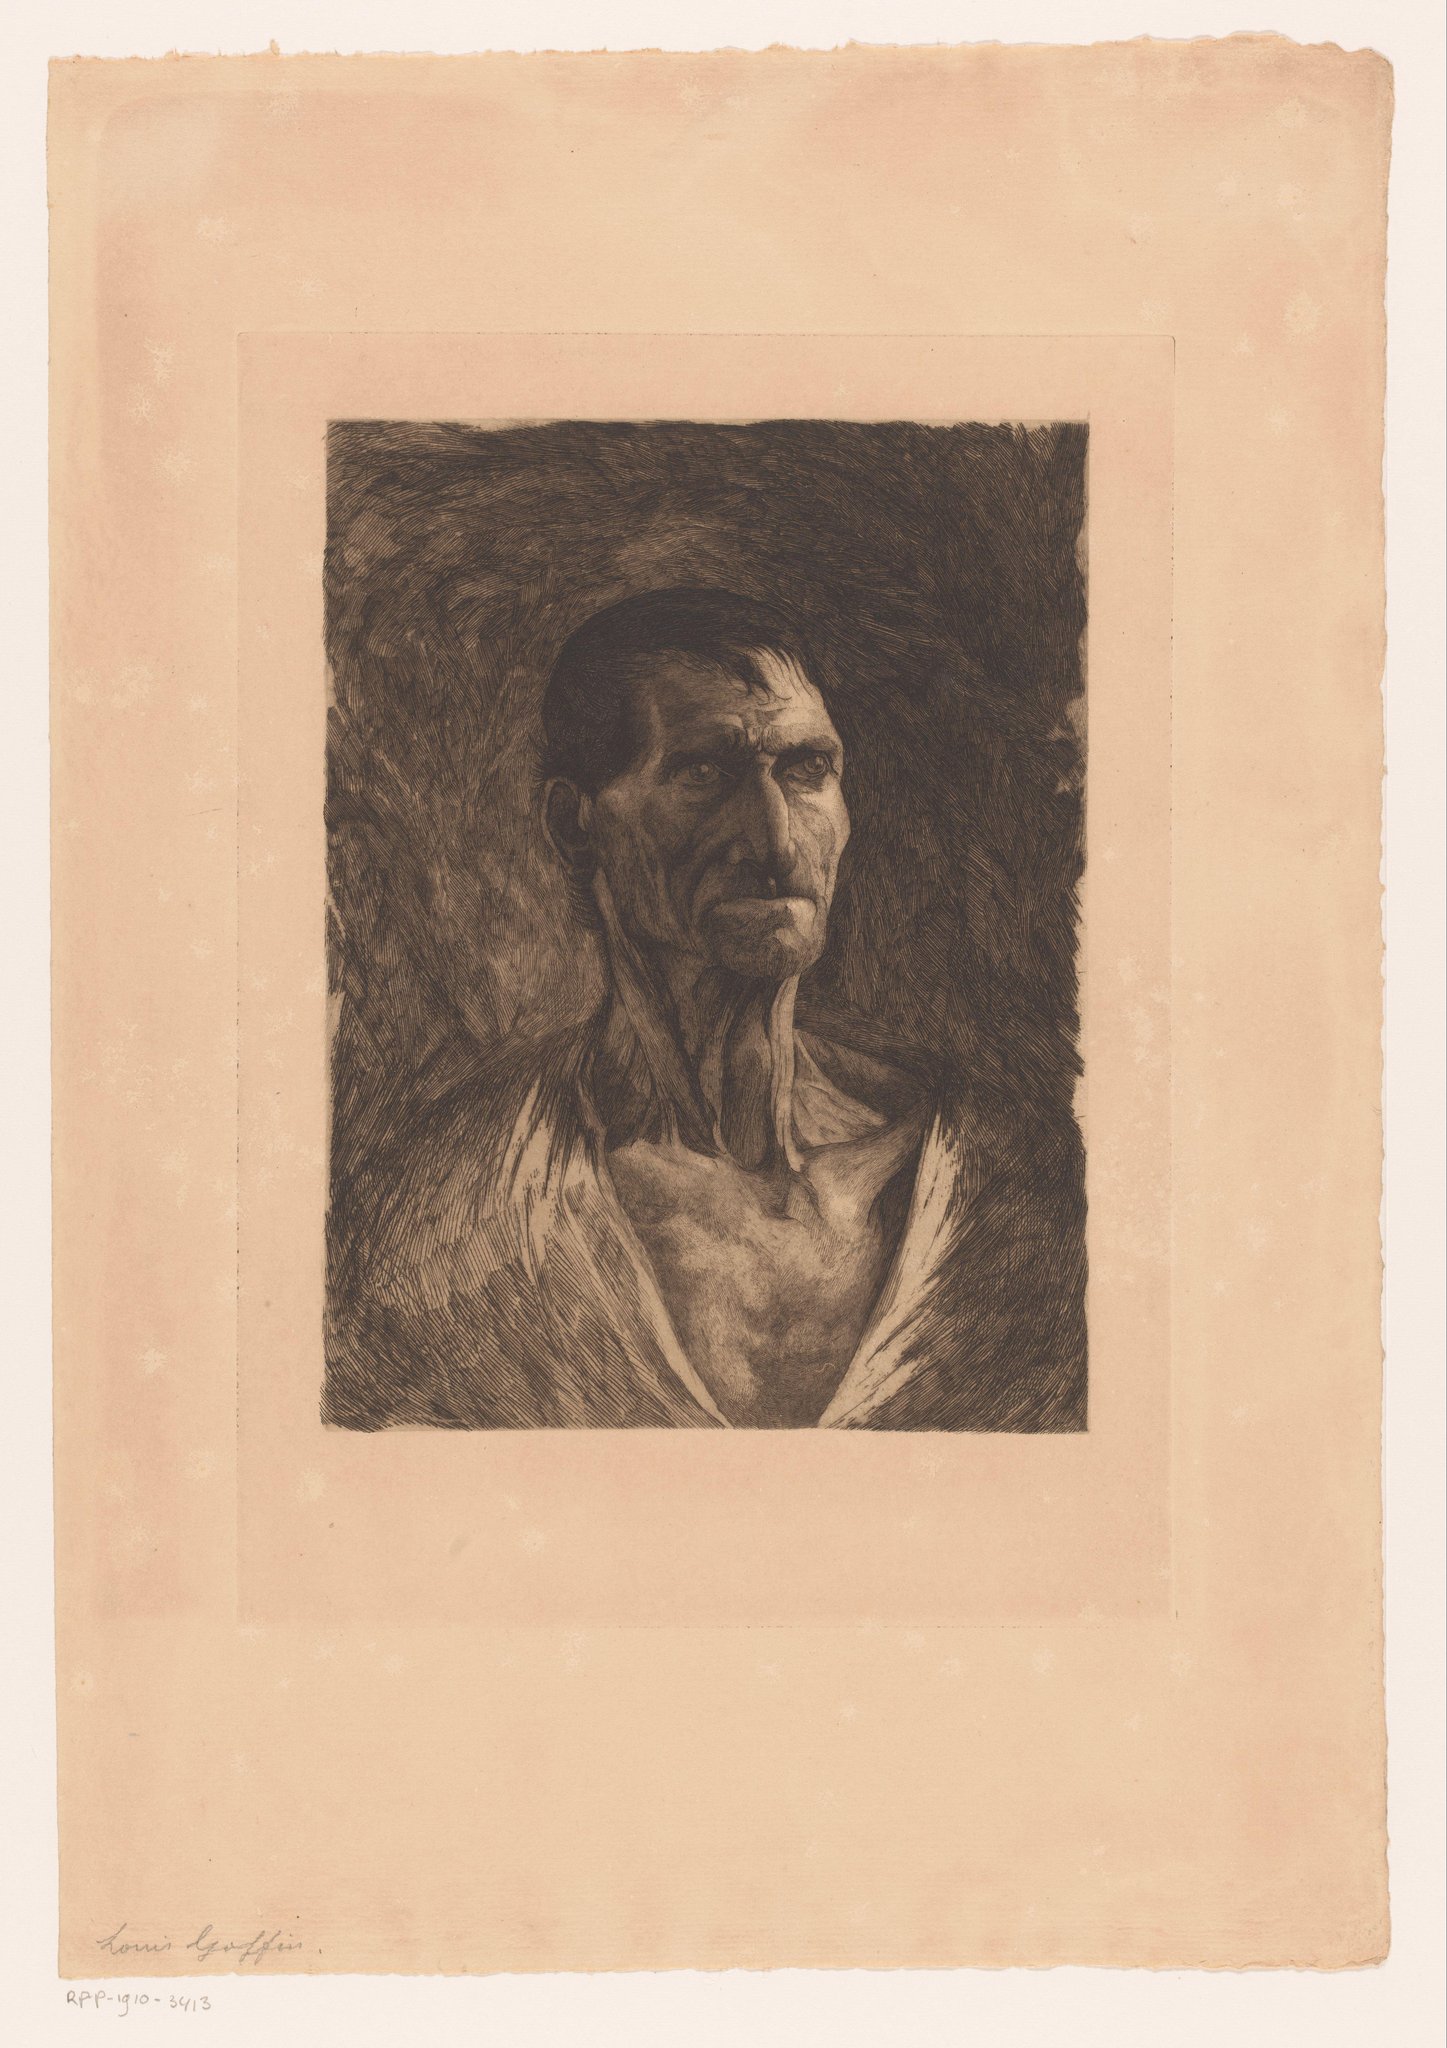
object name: print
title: Buste van een onbekende man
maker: louis goffint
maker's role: print maker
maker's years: 1877-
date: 1887-1910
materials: paper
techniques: etching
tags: adult man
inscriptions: collector's mark: Lugt 2228